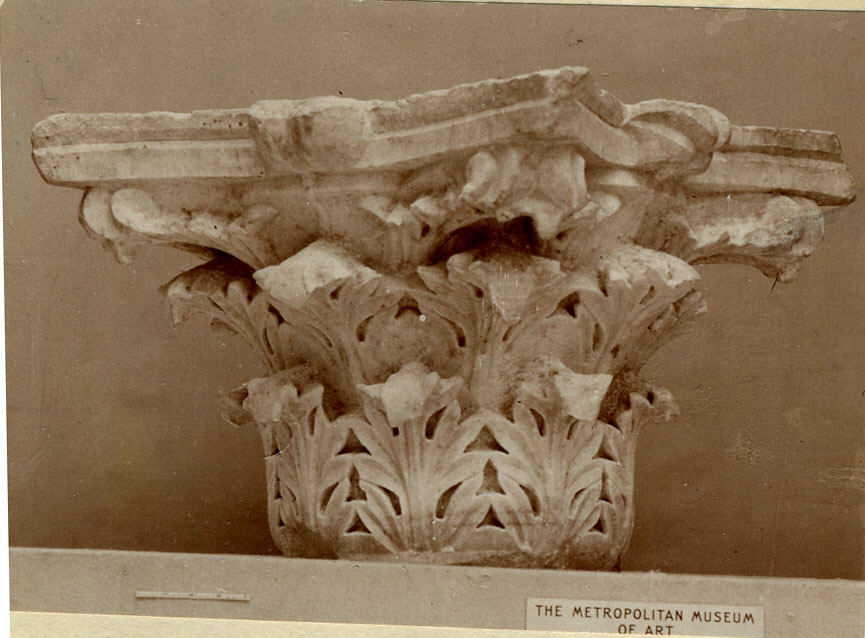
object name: capital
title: Capital with Acanthus Leaves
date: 301-400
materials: marble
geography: egypt